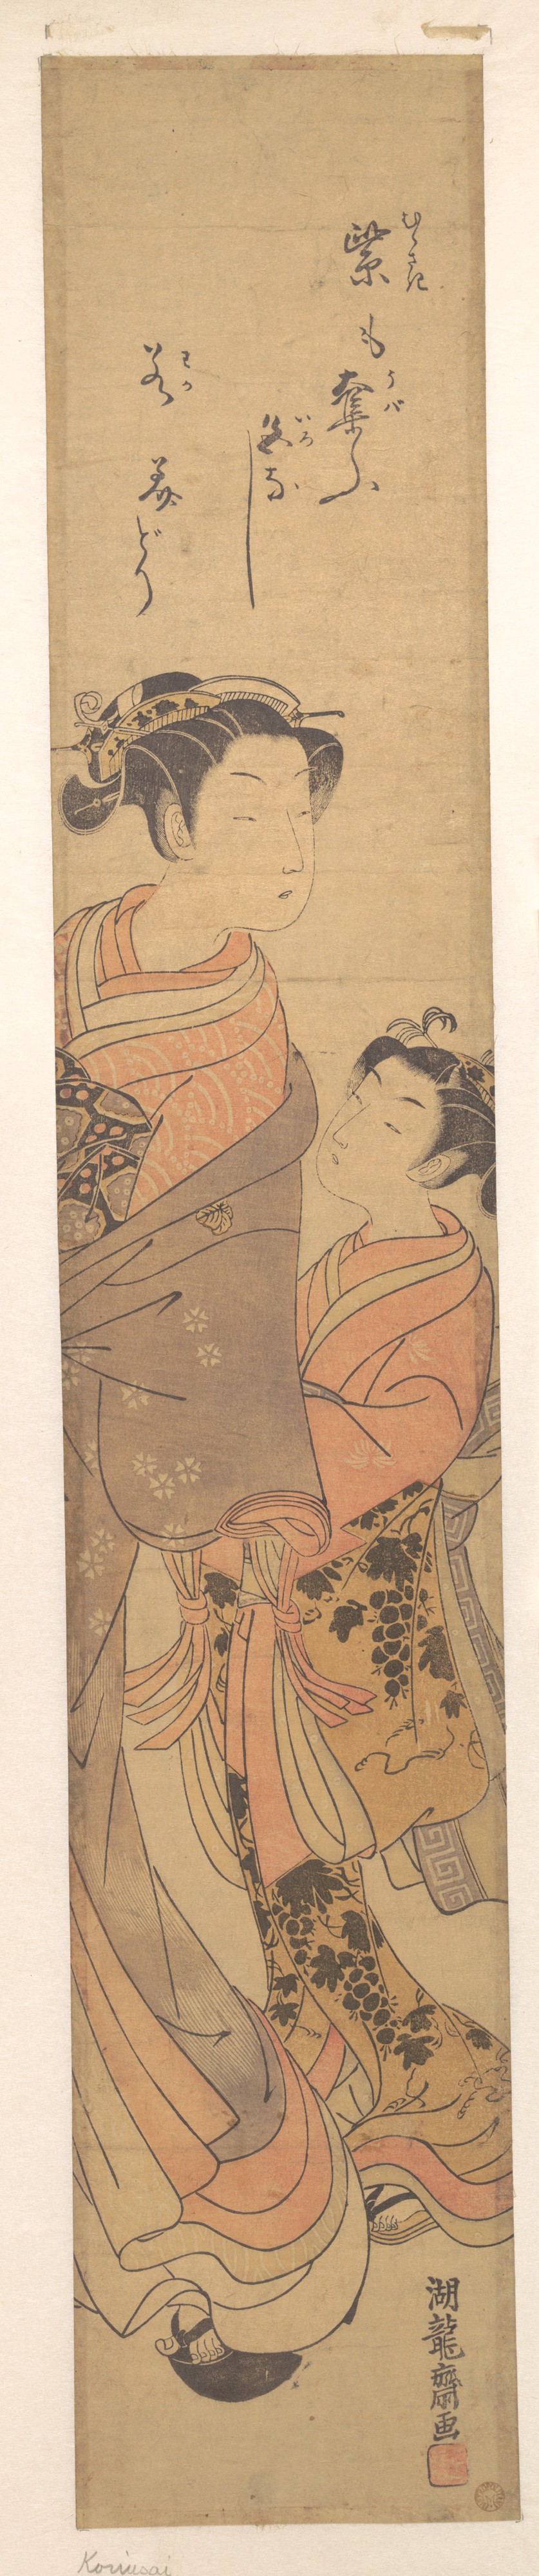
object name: print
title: A Girl with an Attendant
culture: japanese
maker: isoda koryūsai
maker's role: artist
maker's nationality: japanese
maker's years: 1735-1790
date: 1770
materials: ink, paper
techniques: woodblock print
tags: girls